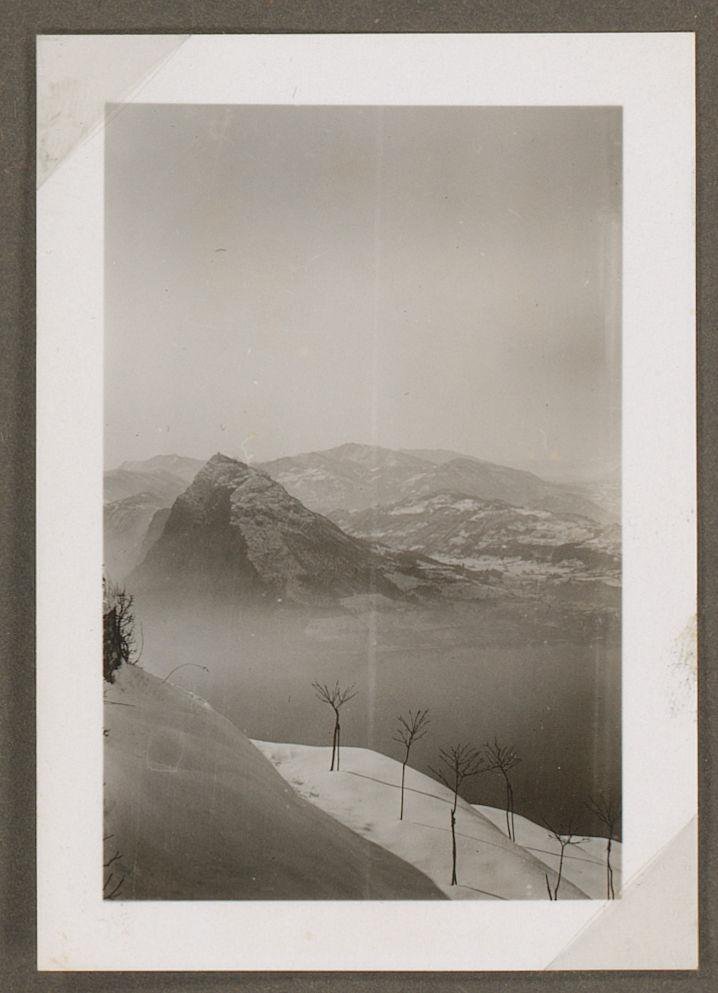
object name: photograph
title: Rulinhotel Monte Bré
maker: Anonymous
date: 1934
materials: photographic support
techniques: gelatin silver print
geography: lugano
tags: snow, mountains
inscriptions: number: ‘35’